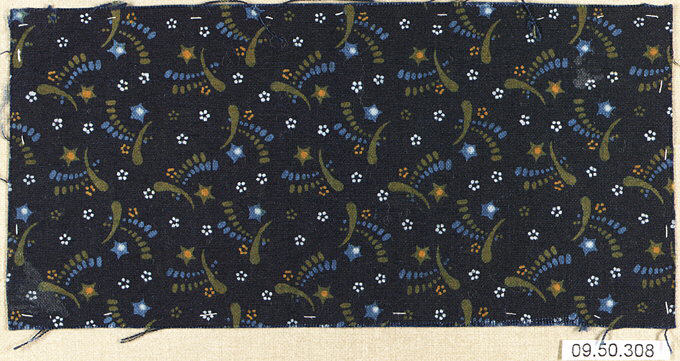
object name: piece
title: Piece (one of 116)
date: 1801-1900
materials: cotton